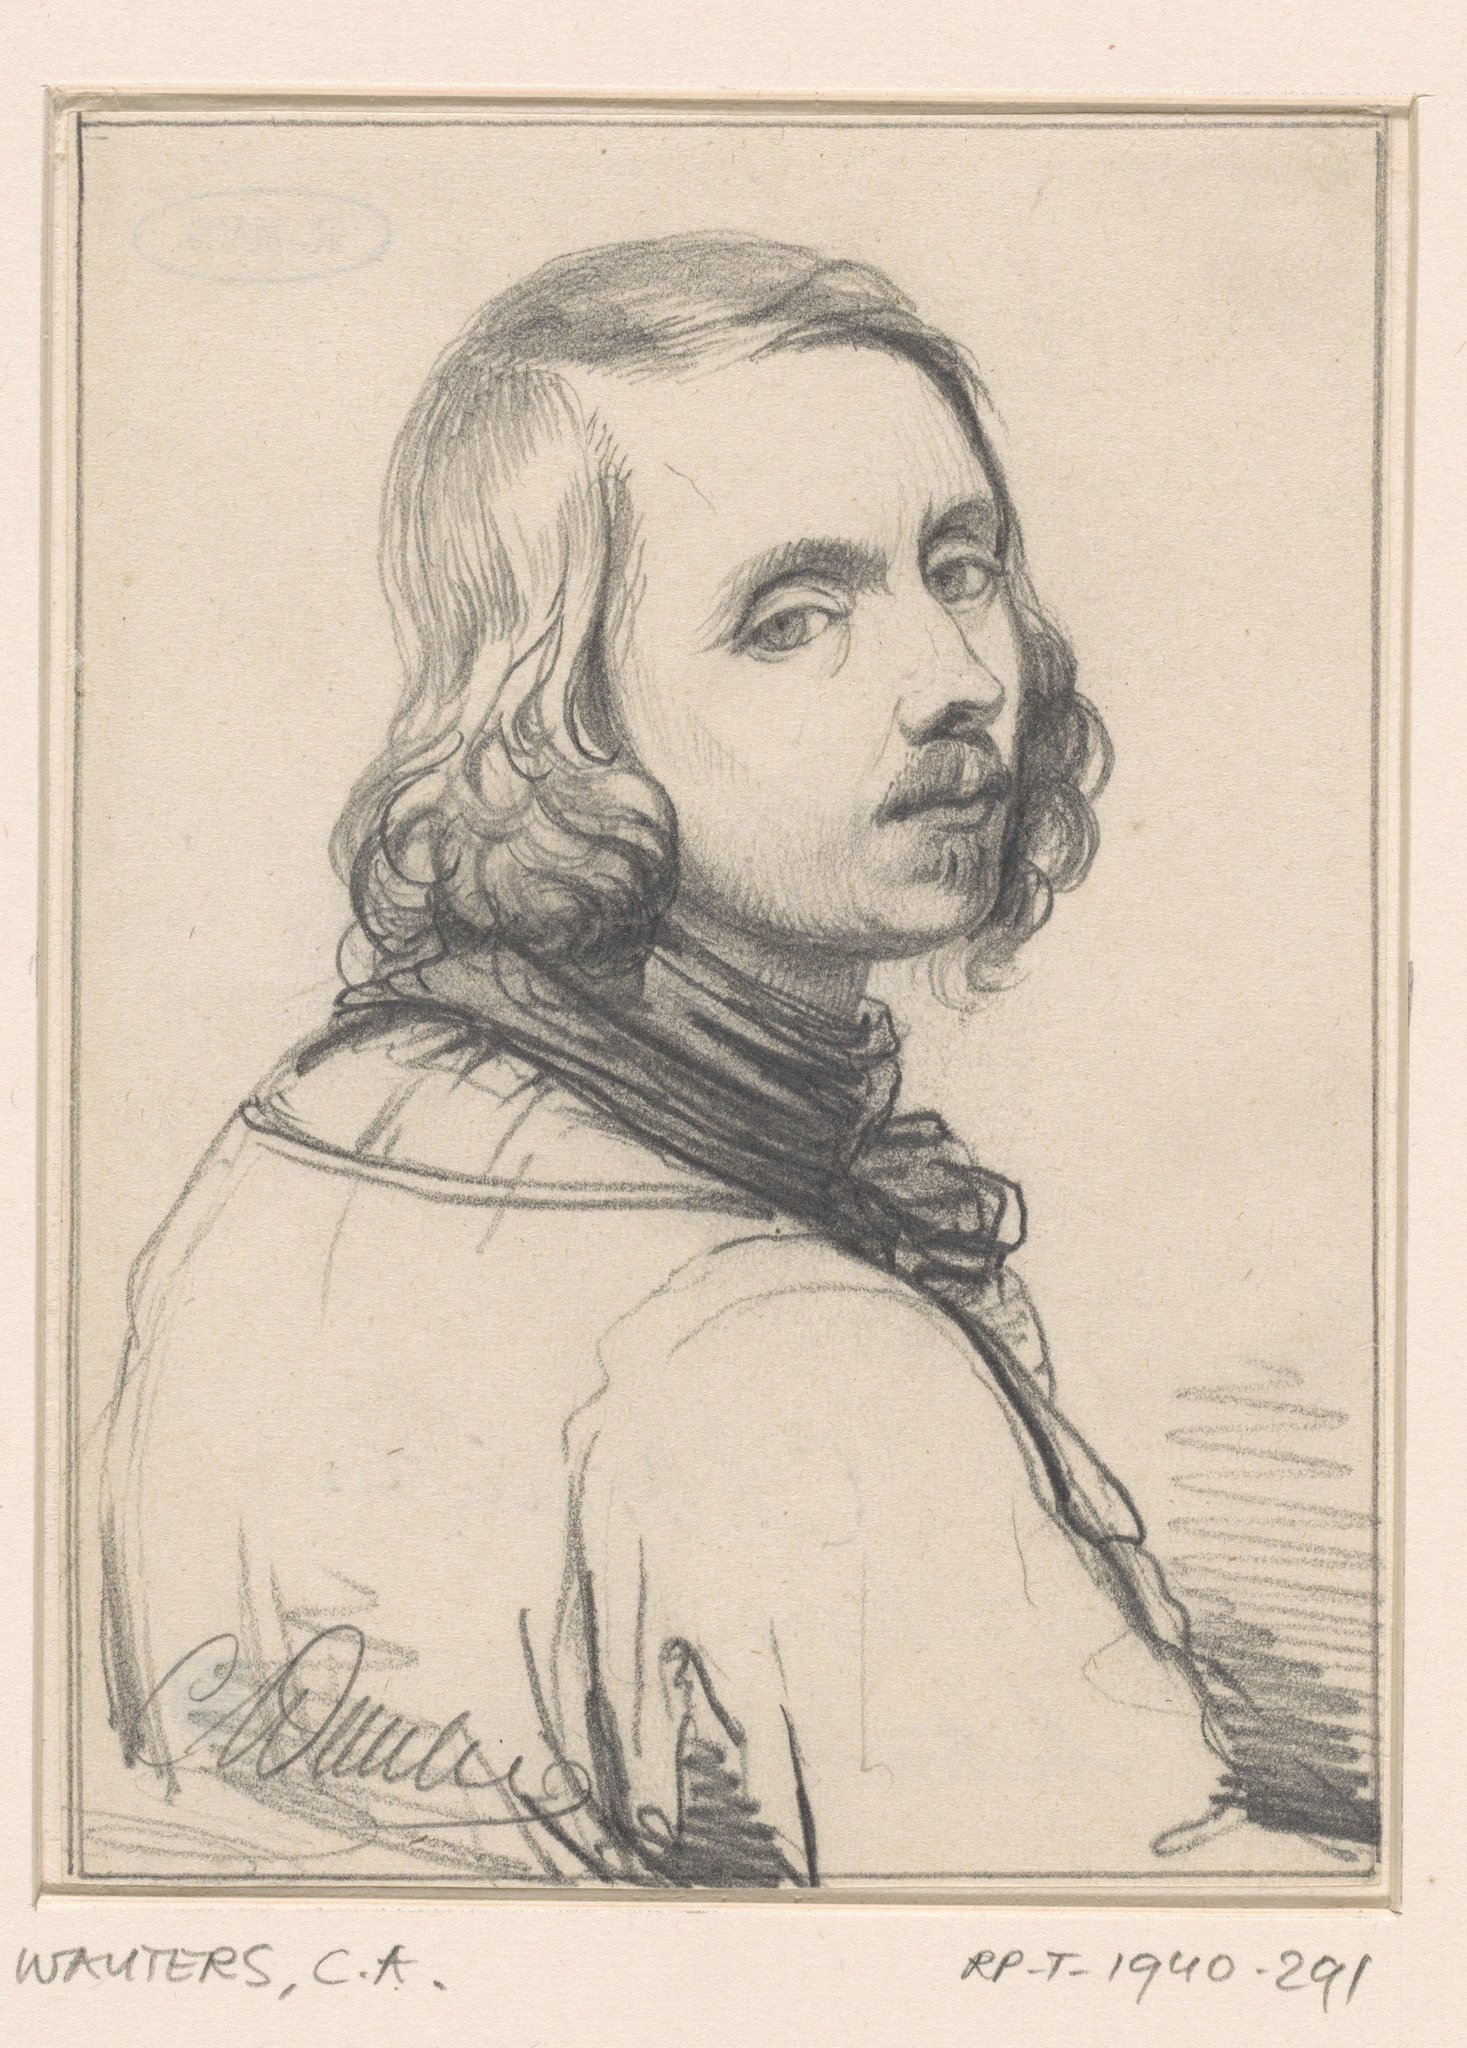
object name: drawing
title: Zelfportret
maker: charles augustin wauters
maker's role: draughtsman, print maker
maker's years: 1811-1869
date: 1821-1869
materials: paper, pencil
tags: boom, mechelen, print maker, draughtsman, charles augustin wauters, historical persons, portrait, self-portrait of artist, portrait, self-portrait of graphic artist, portrait, self-portrait of draughtsman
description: Zelfportret van de graveur en tekenaar Charles Augustin Wauters.